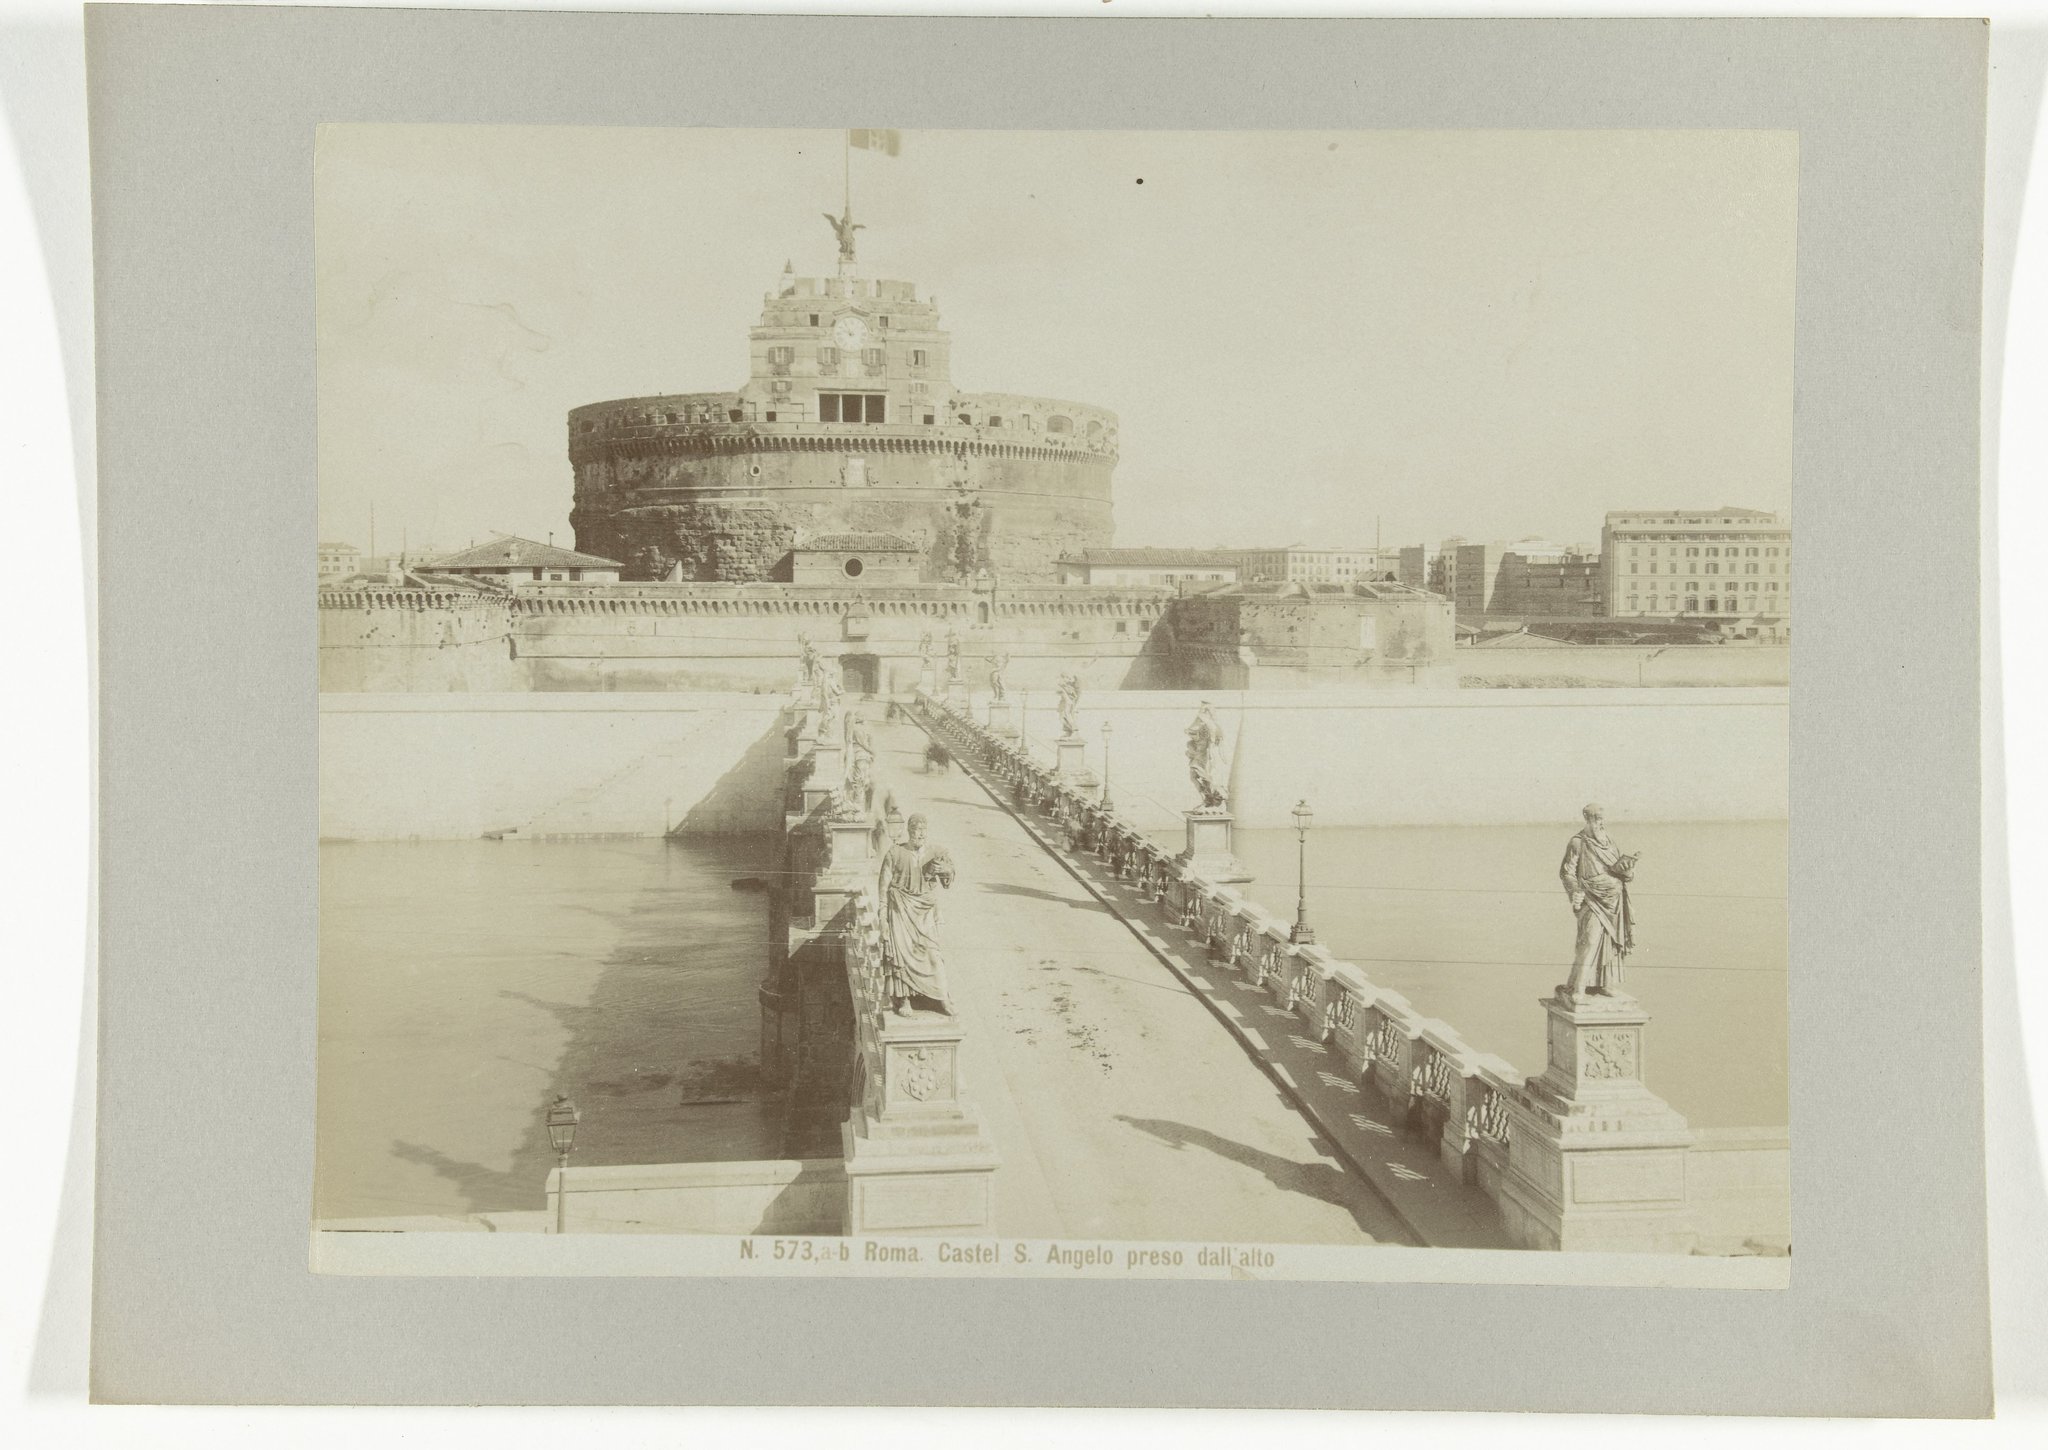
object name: photograph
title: Engelenbrug en Engelenburcht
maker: Anonymous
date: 1880-1904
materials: cardboard, paper, photographic support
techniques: albumen print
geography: rome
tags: engelenburcht, engelenbrug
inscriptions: number: ‘34.’